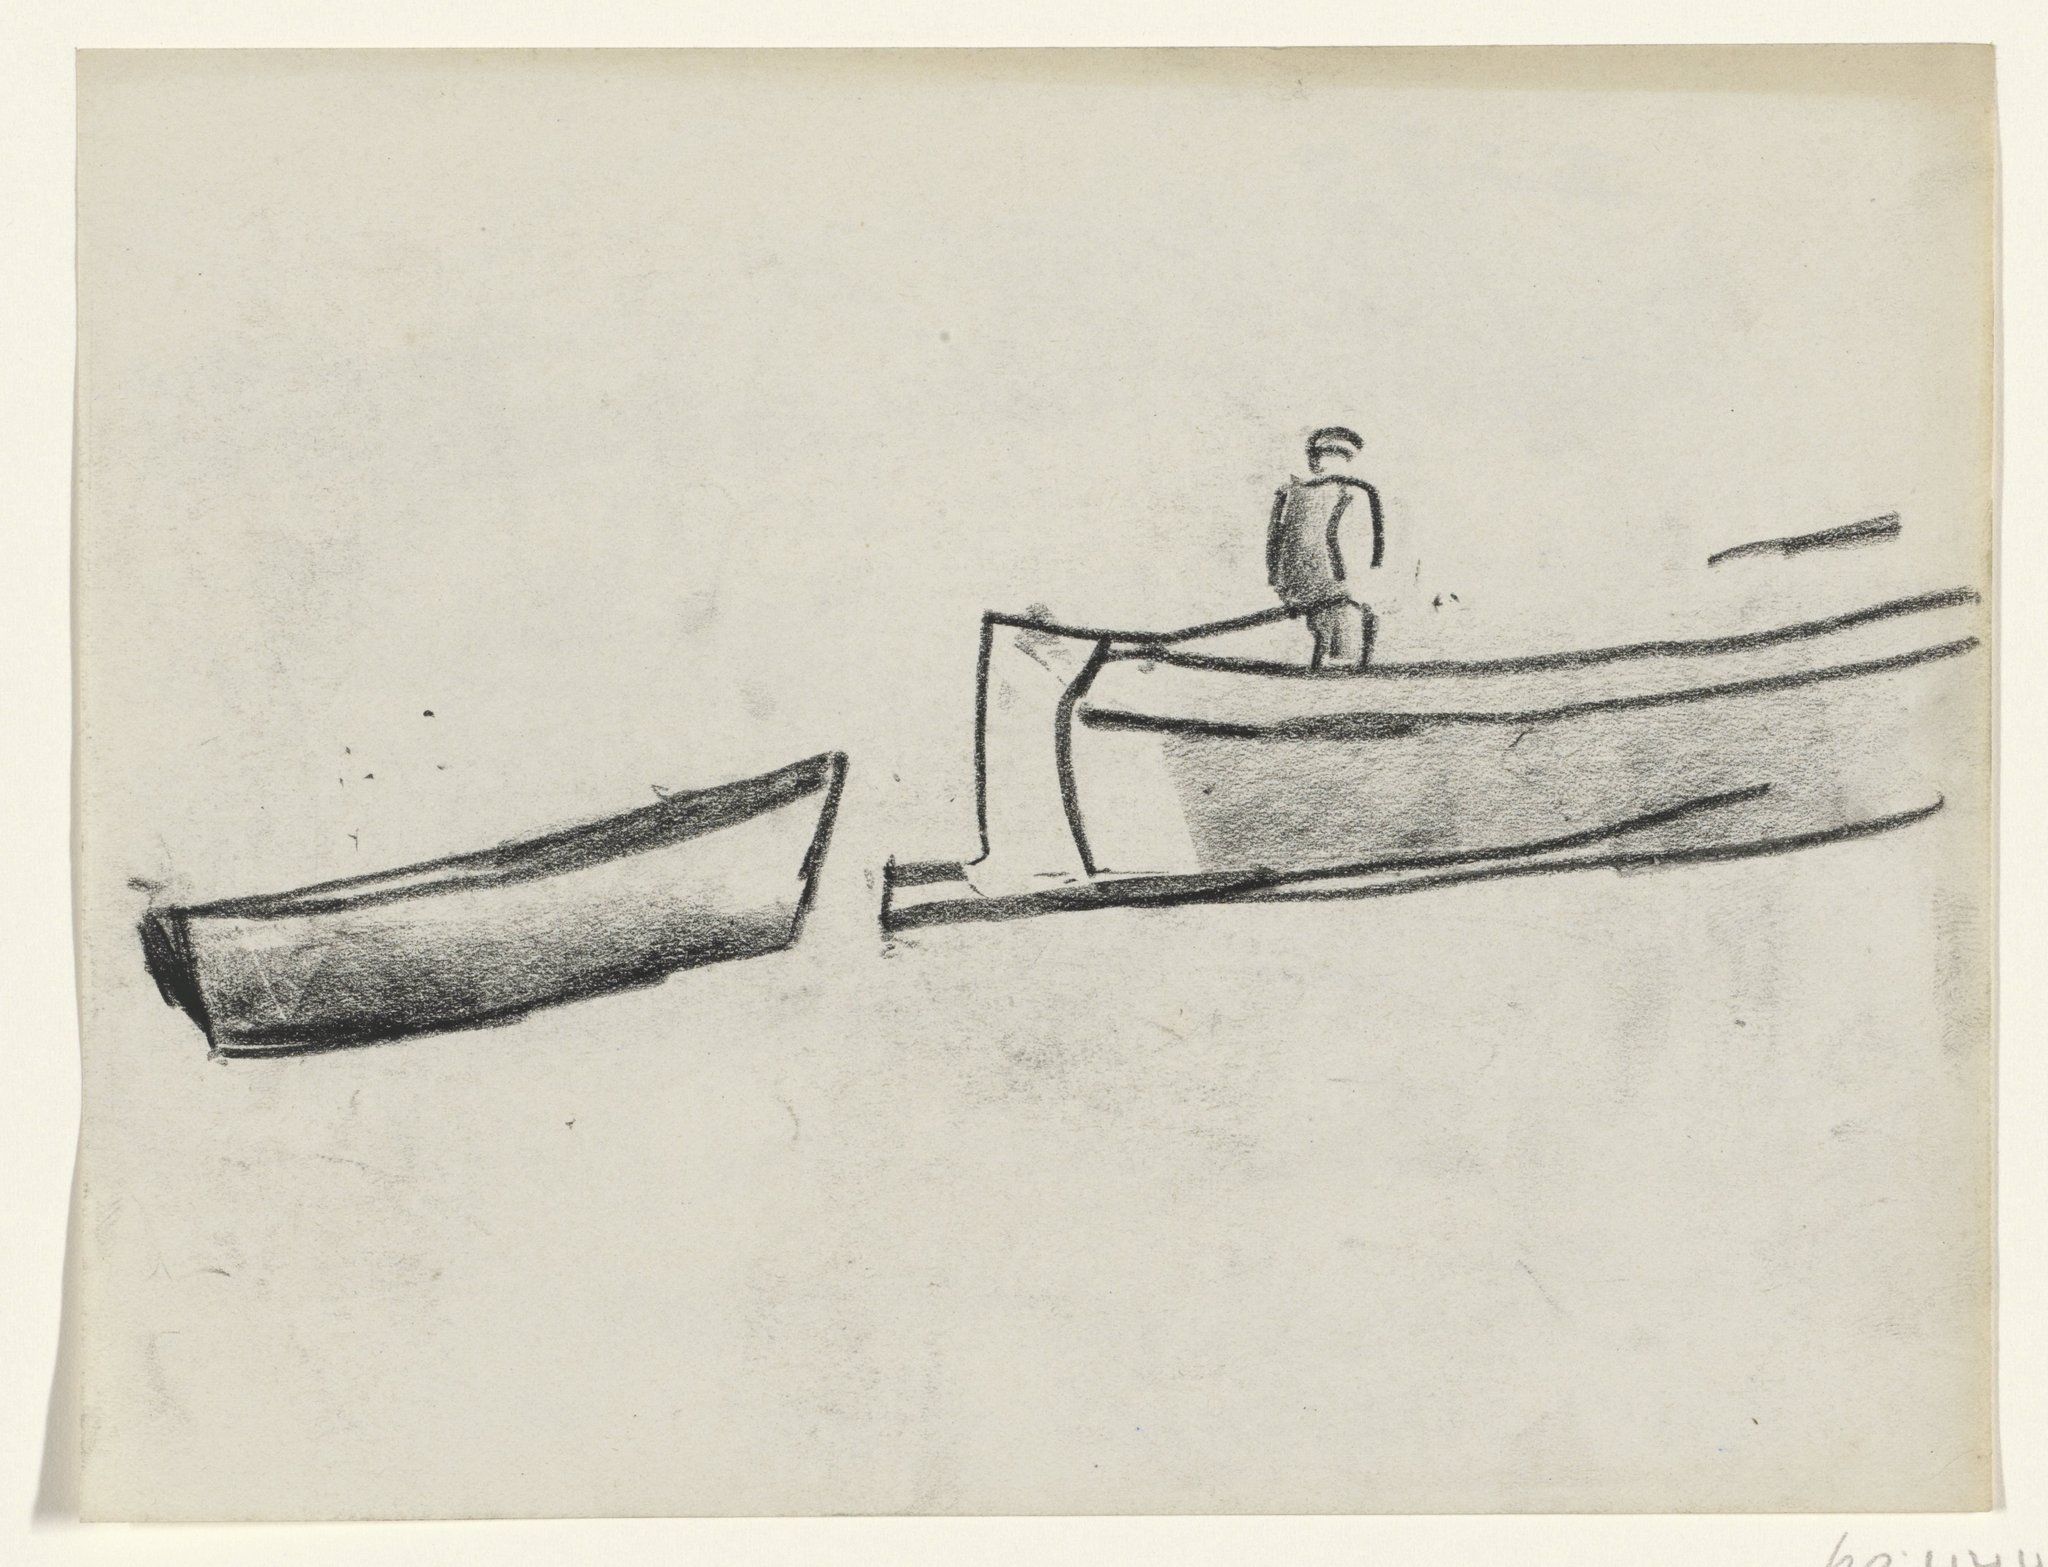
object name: drawing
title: Schip met een man aan het roer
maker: leo gestel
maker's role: draughtsman, print maker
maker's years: 1881-1941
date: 1891-1941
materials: chalk, paper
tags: ships (in general), rowing-boat, canoe, etc., male sex; man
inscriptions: collector's mark: Lugt 2228